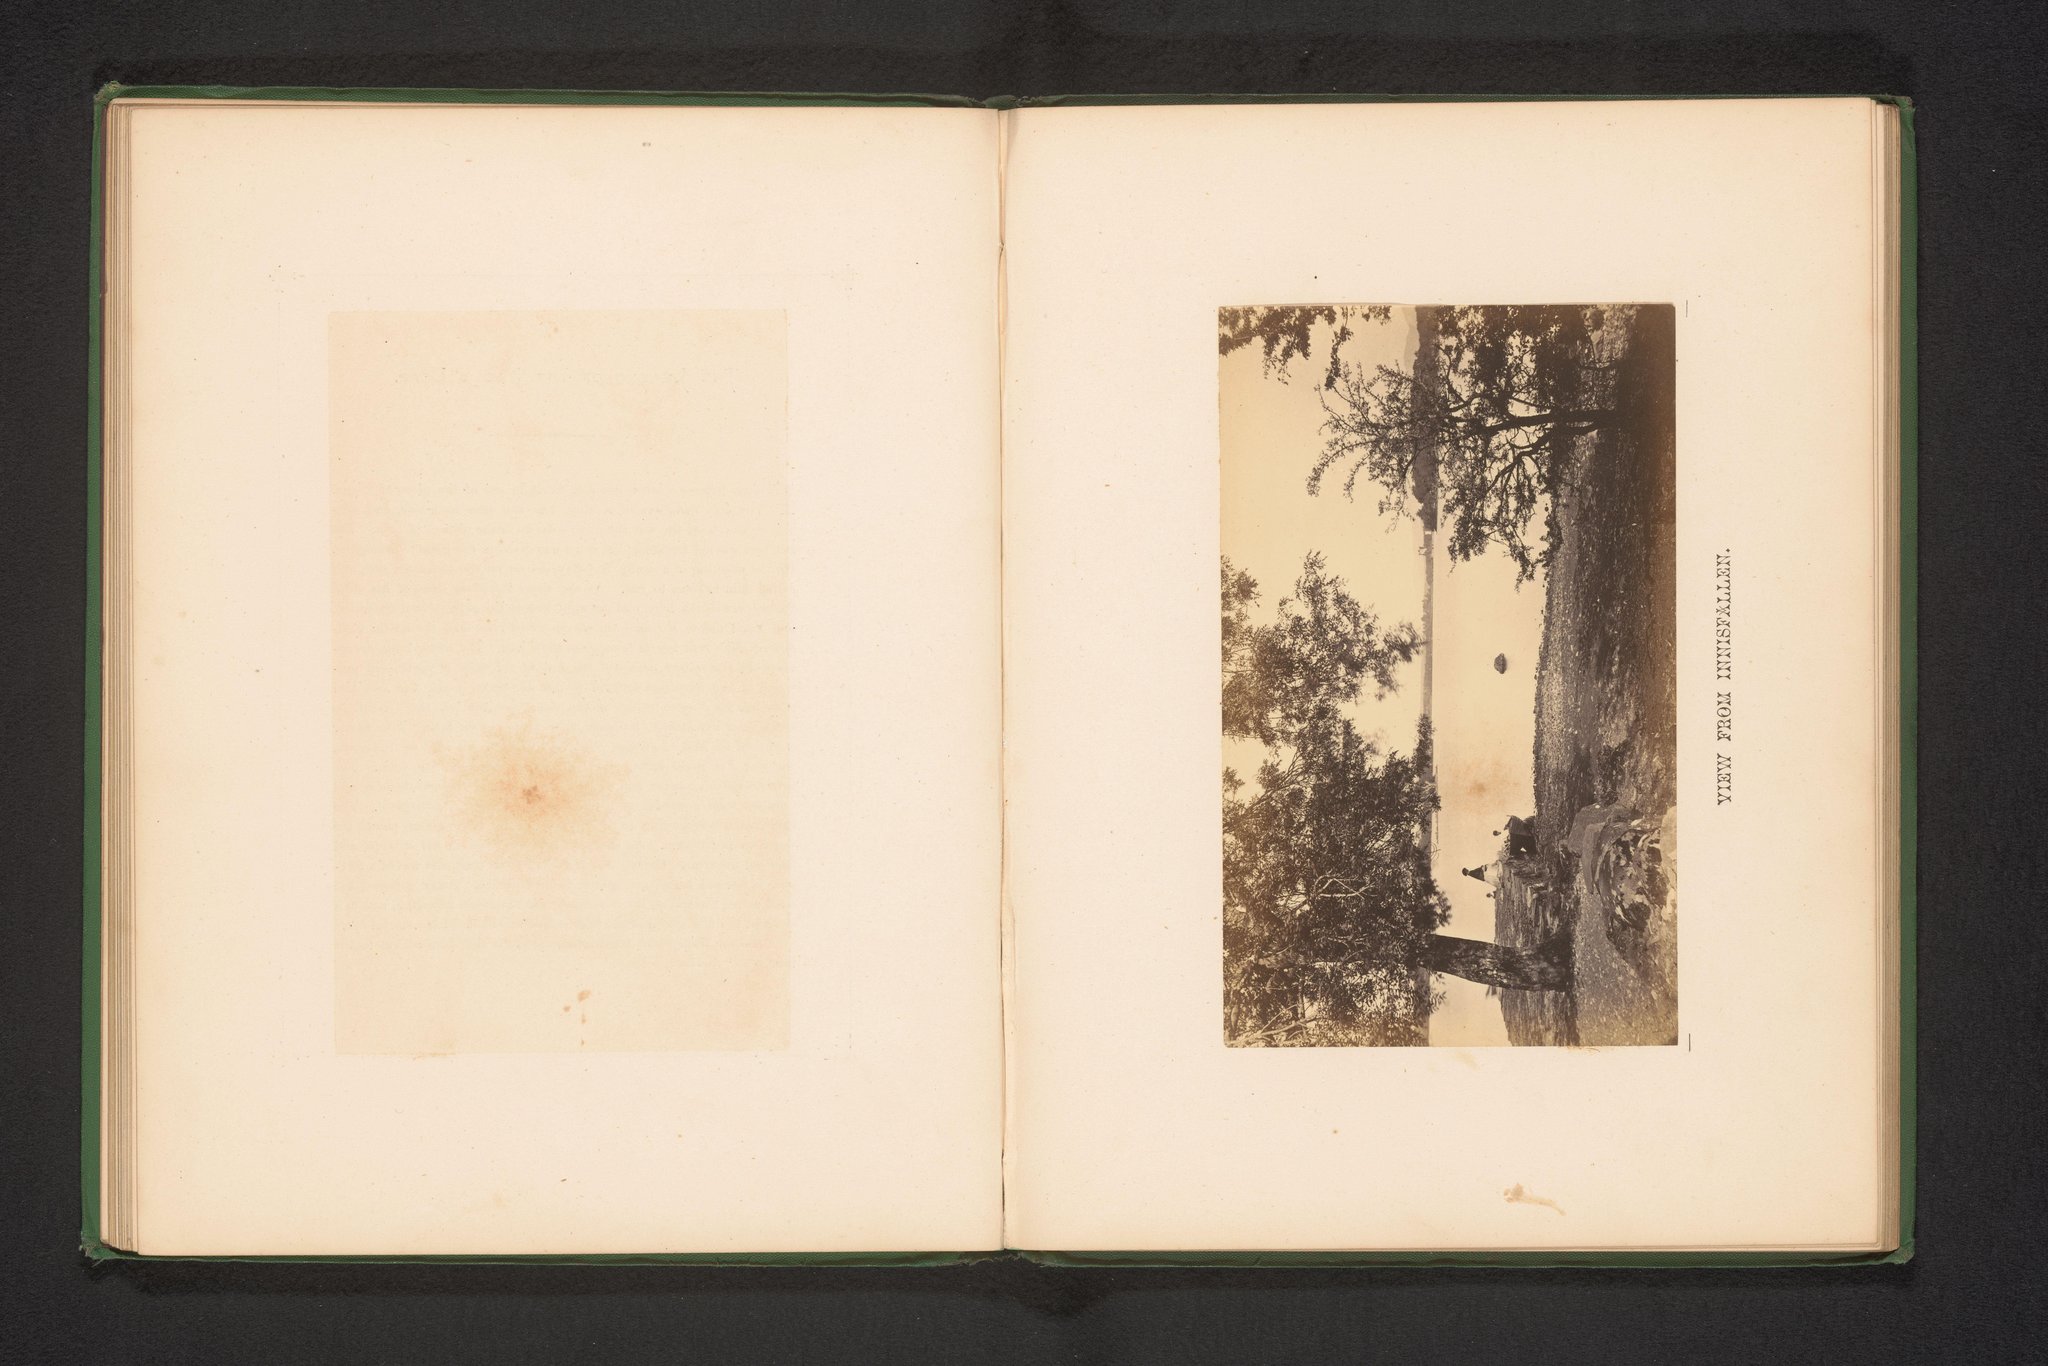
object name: page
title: View from Innisfallen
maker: john hudson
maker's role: fotograaf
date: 1862-1867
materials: photographic support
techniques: albumen print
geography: killarney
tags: adult man, landscapes with waters, waterscapes, seascapes (in the temperate zone)